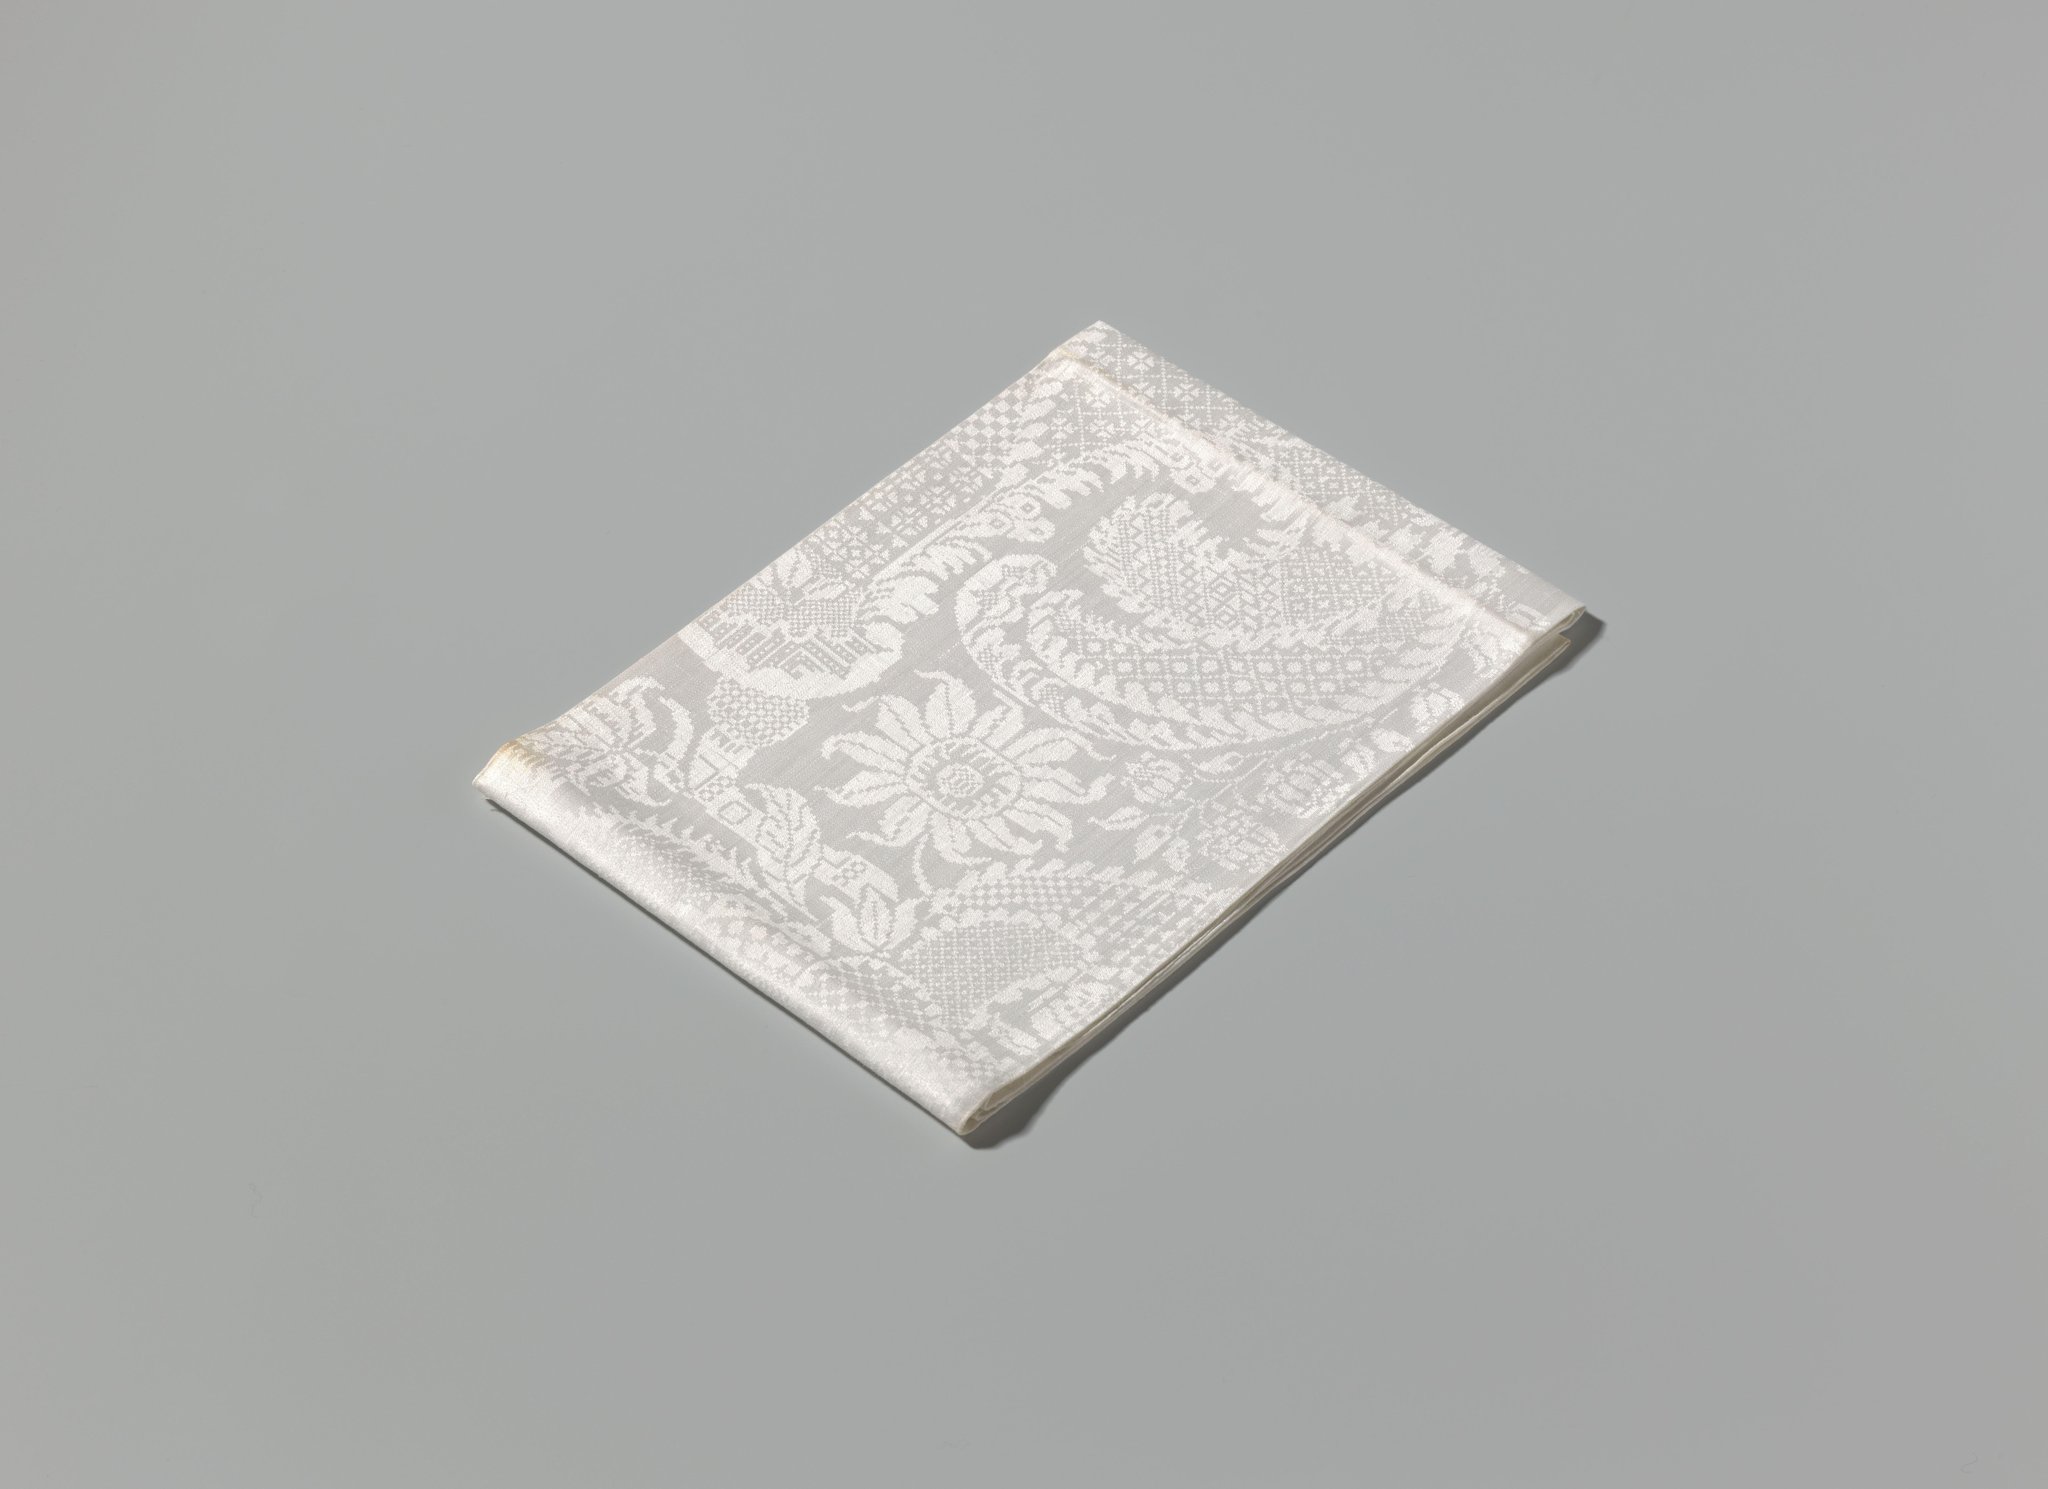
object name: napkin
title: Servet van linnendamast met een voluutpatroon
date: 1723-1730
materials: linen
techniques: damask, weave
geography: northern netherlands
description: Wit linnendamasten servet met patroon van voluten, merk: kroon WG 1.